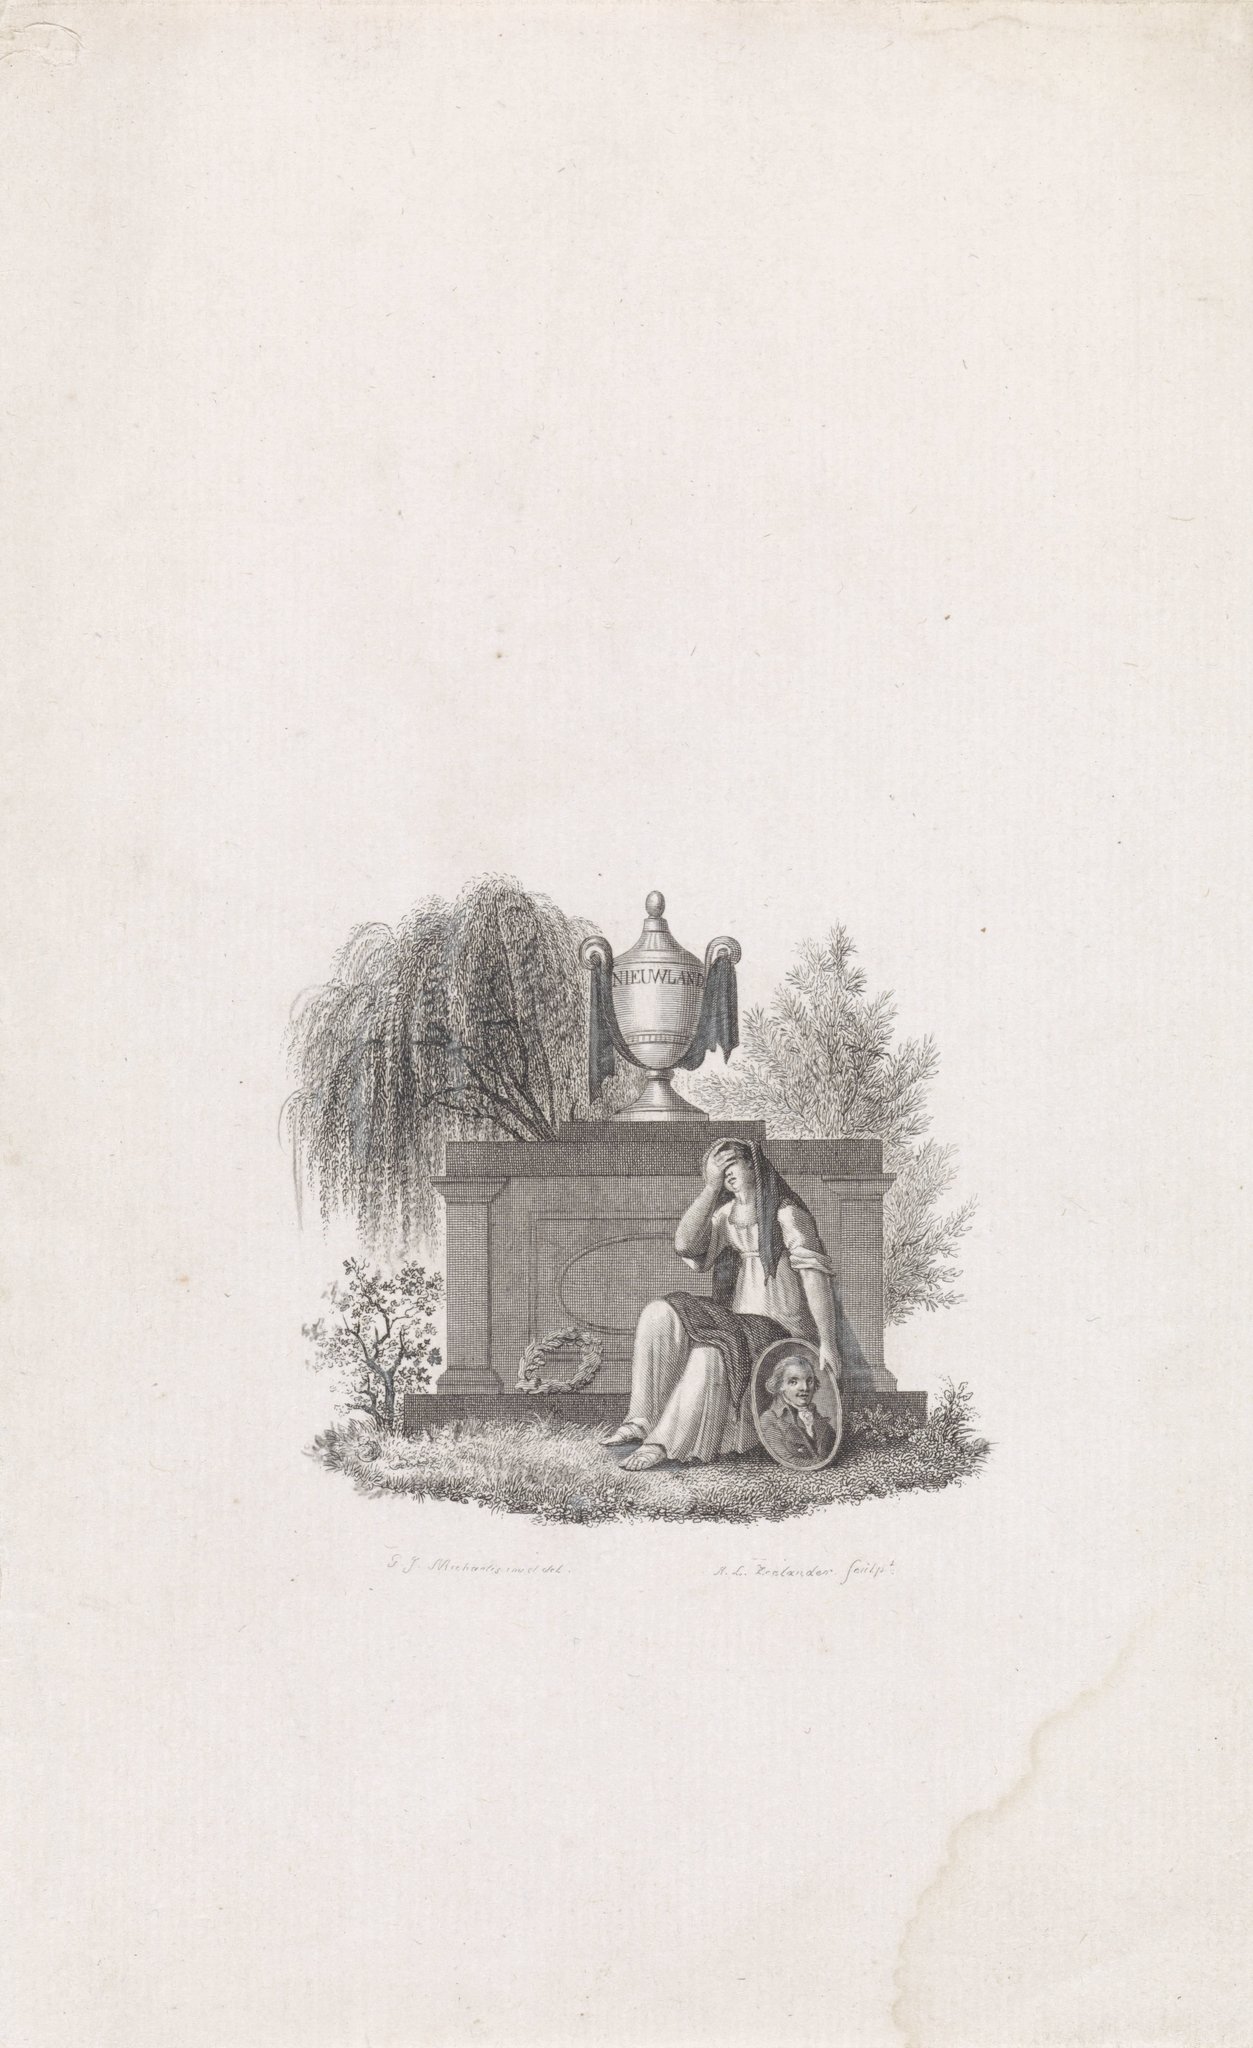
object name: print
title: Gedenkteken voor Pieter Nieuwland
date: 1799-1856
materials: paper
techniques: engraving, etching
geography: amsterdam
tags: grave, tomb and other grave-forms and grave-markers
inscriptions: collector's mark: Lugt 2228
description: Een gedenkteken ter nagedachtenis van hoogleraar in de wis- en natuurkunde Pieter Nieuwland. Een vrouw zit treurend onder het monument met het portret van Pieter Nieuwland in de hand.